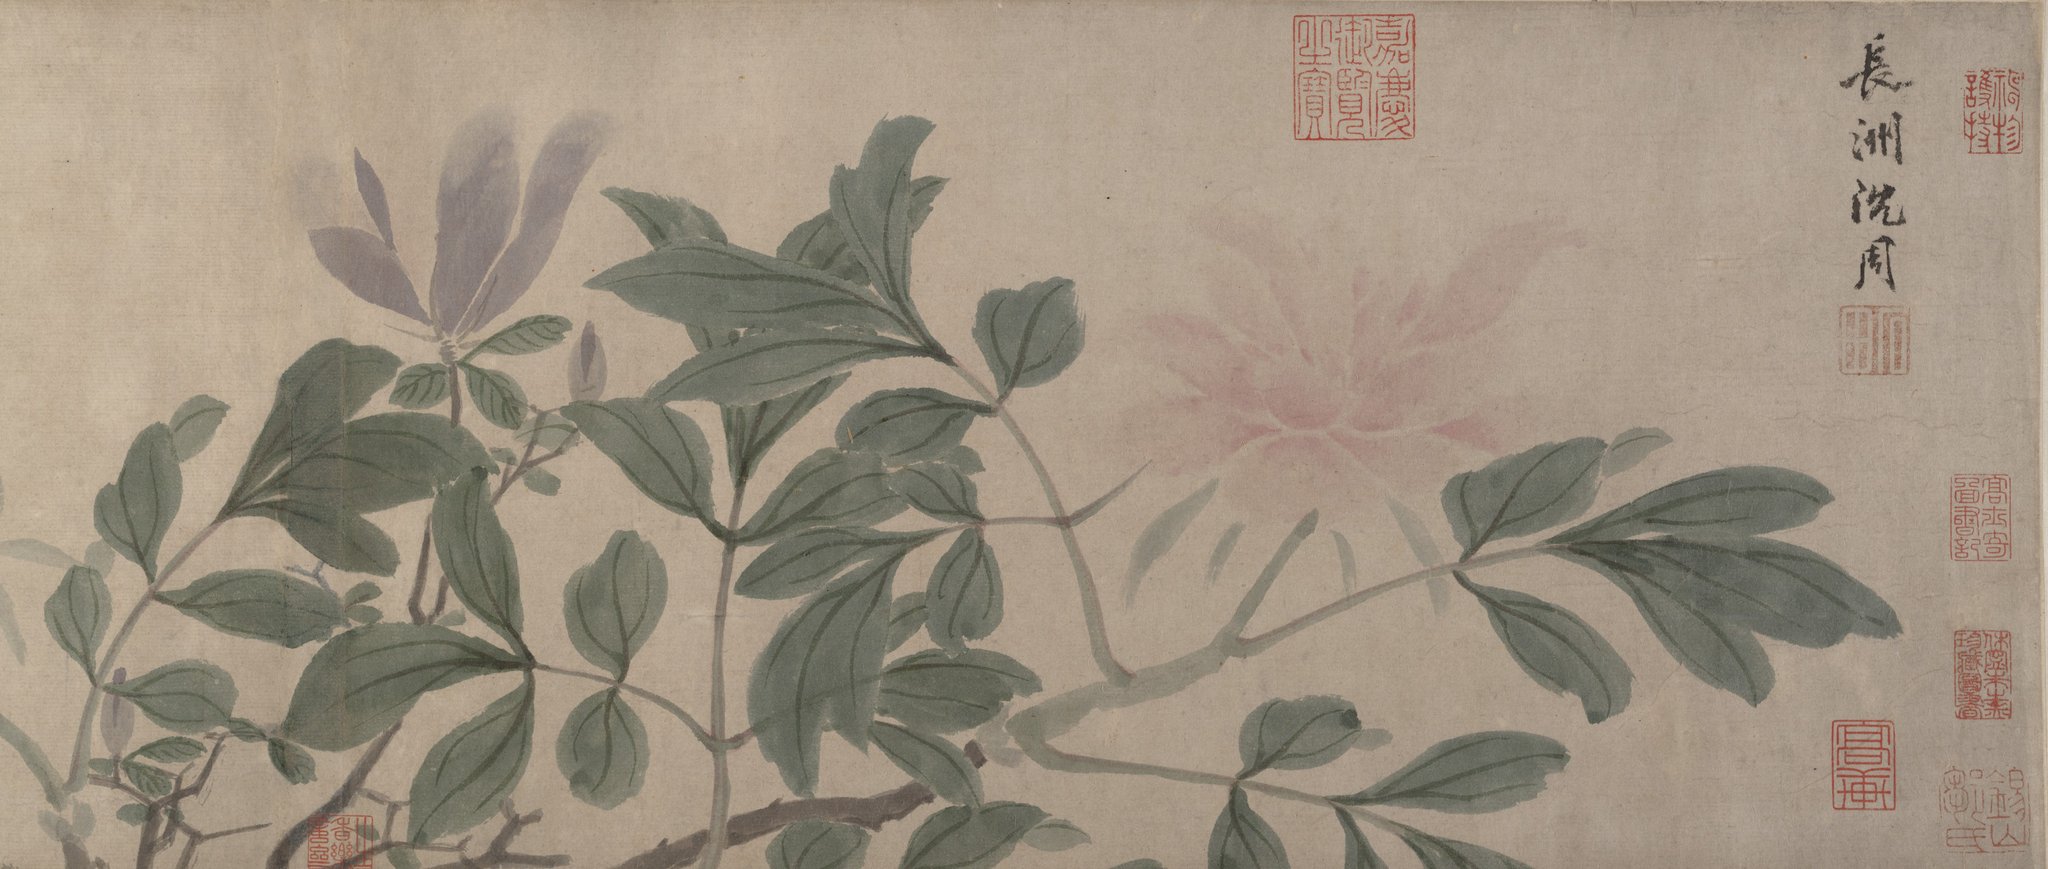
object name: handscroll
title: Flowers of the Four Seasons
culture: chinese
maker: shen zhou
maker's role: artist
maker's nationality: chinese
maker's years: 1427-1509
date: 1427-1509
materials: ink, paper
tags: flowers